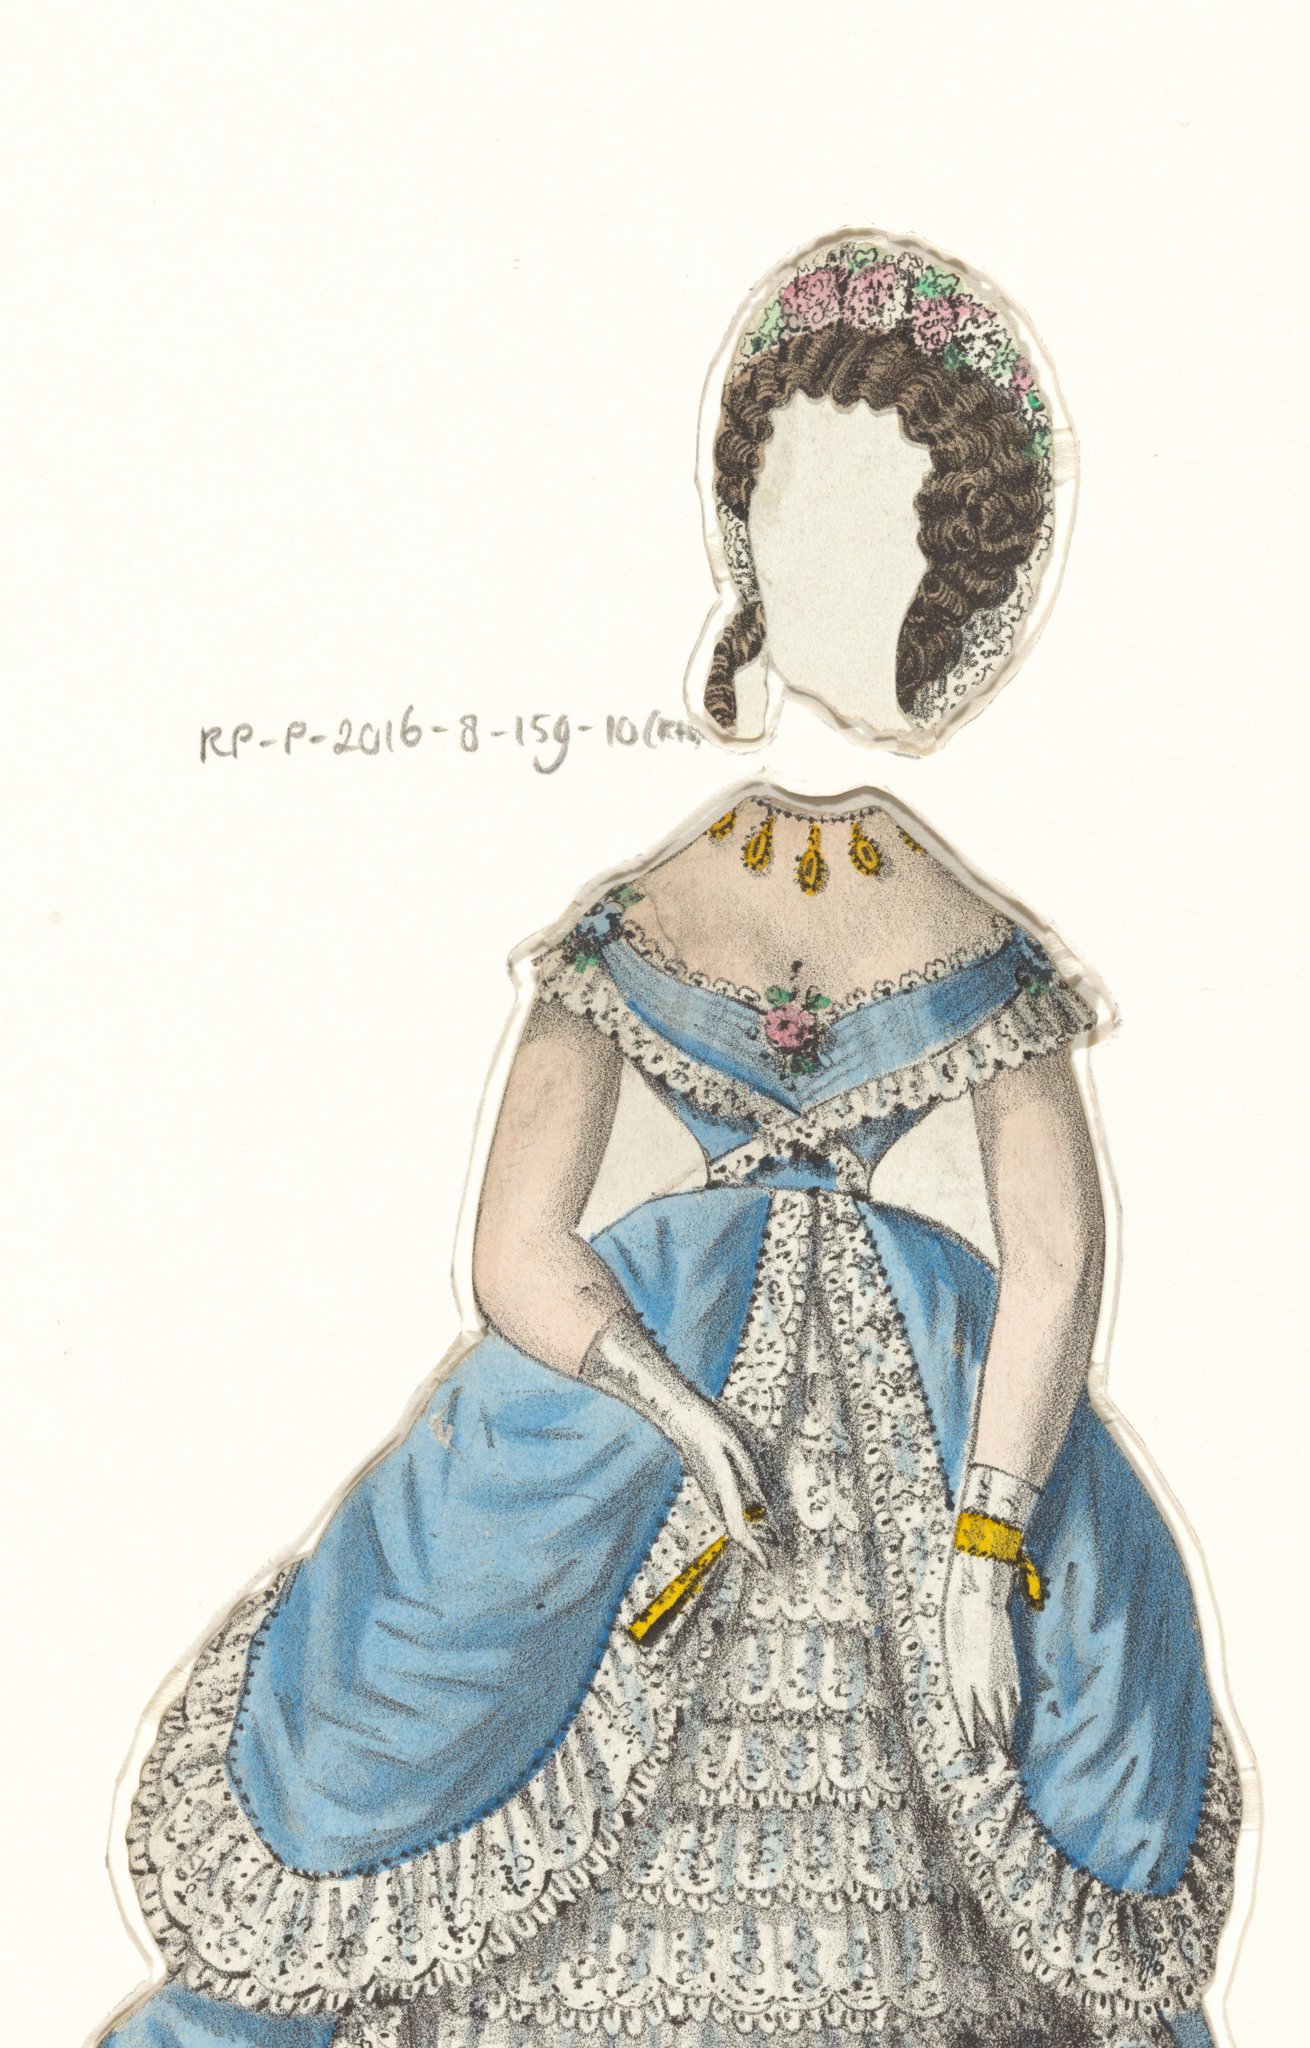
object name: fashion print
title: Kapsel voor een uitknippop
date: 1825-1875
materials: paper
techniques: engraving, hand coloring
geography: paris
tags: fashion plates